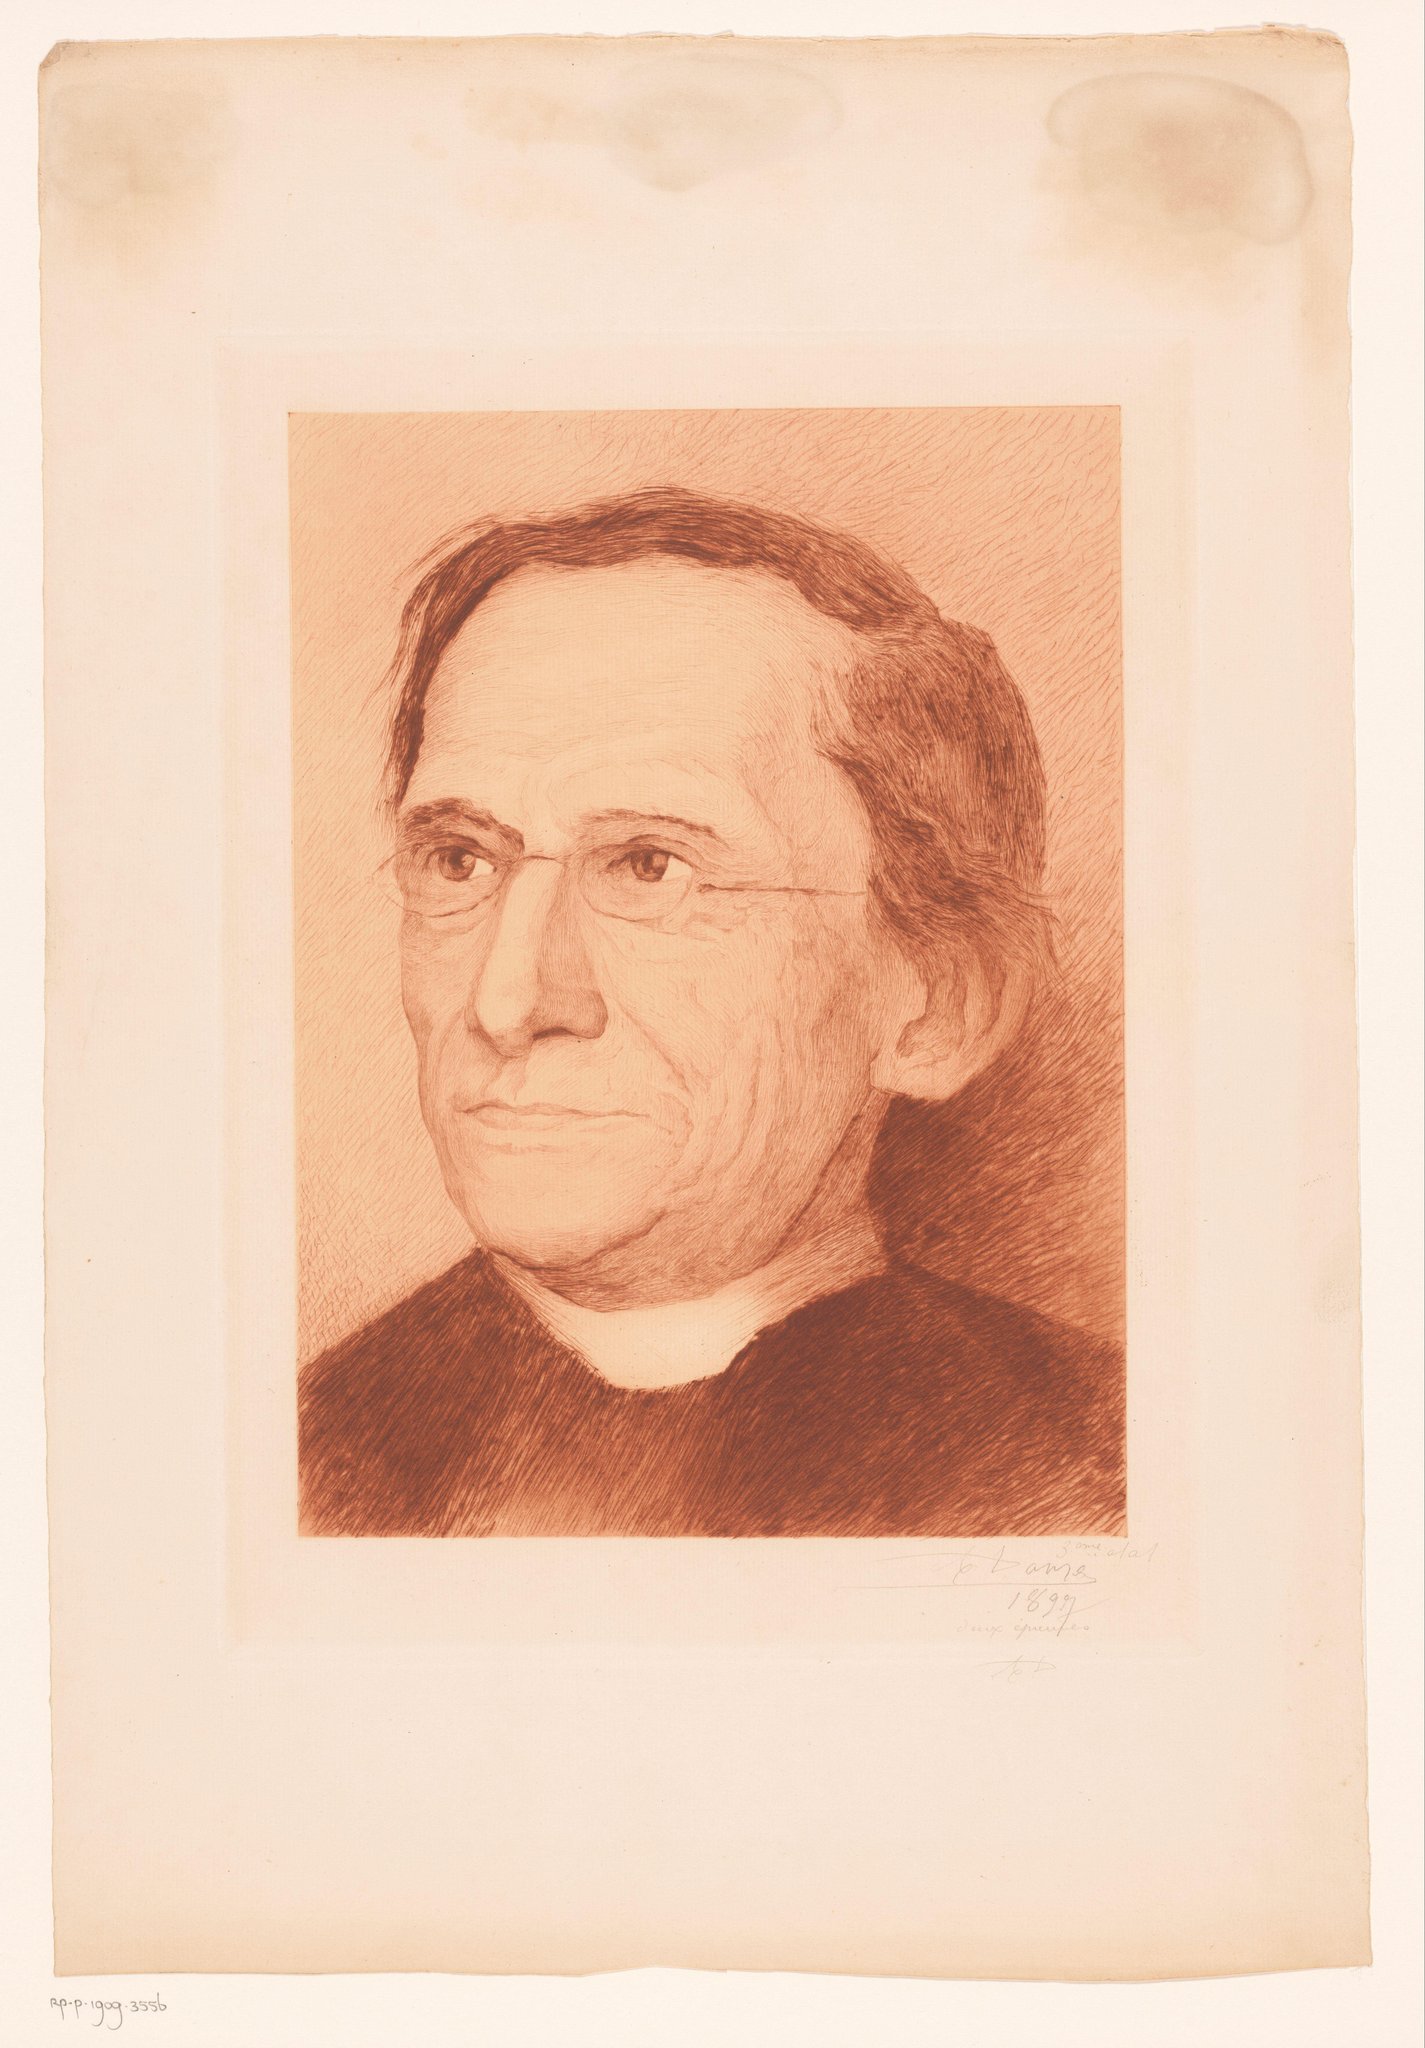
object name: print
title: Portret van Charles de Harlez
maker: auguste danse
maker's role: print maker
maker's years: 1829-1929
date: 1897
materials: paper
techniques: drypoint, etching, intaglio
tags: louvain, priest, historical person (...) - historical person (...) portrayed alone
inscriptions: collector's mark: Lugt 2228, annotation: ‘3eme etat; deux epreuves’, watermark: ‘MBM [=Arches Ingres MBM]’